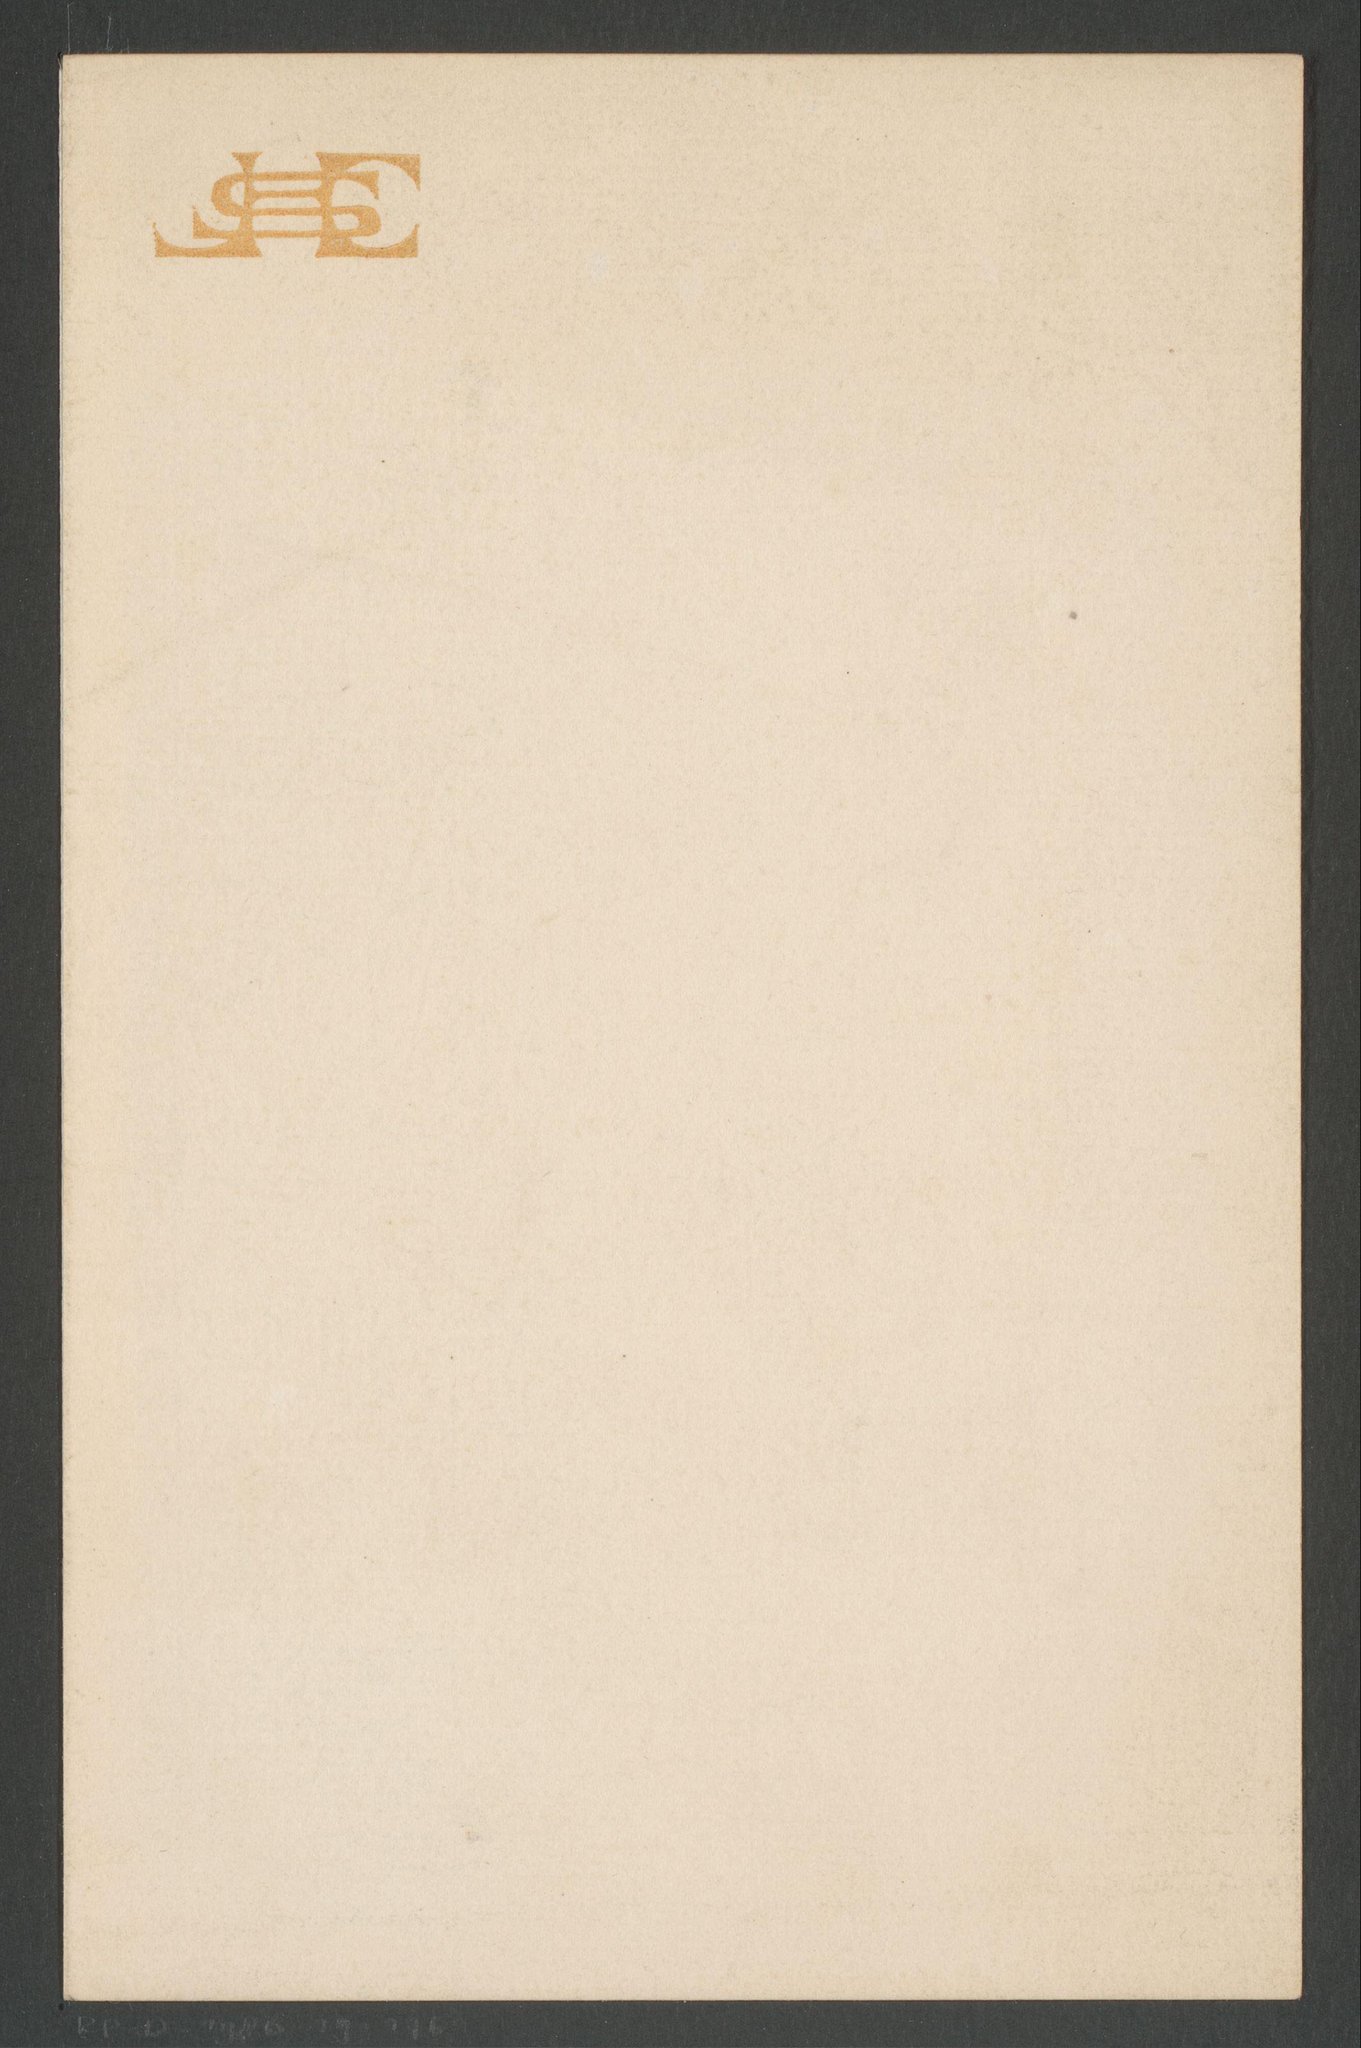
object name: print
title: Briefpapier met monogram SHCL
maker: reinier willem petrus de vries (1874-1953)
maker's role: draughtsman, print maker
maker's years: 1874-1953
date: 1884-1952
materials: paper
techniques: relief print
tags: magic mathematical figures; magic numbers, words, monograms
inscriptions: collector's mark: ‘R:MVS.’